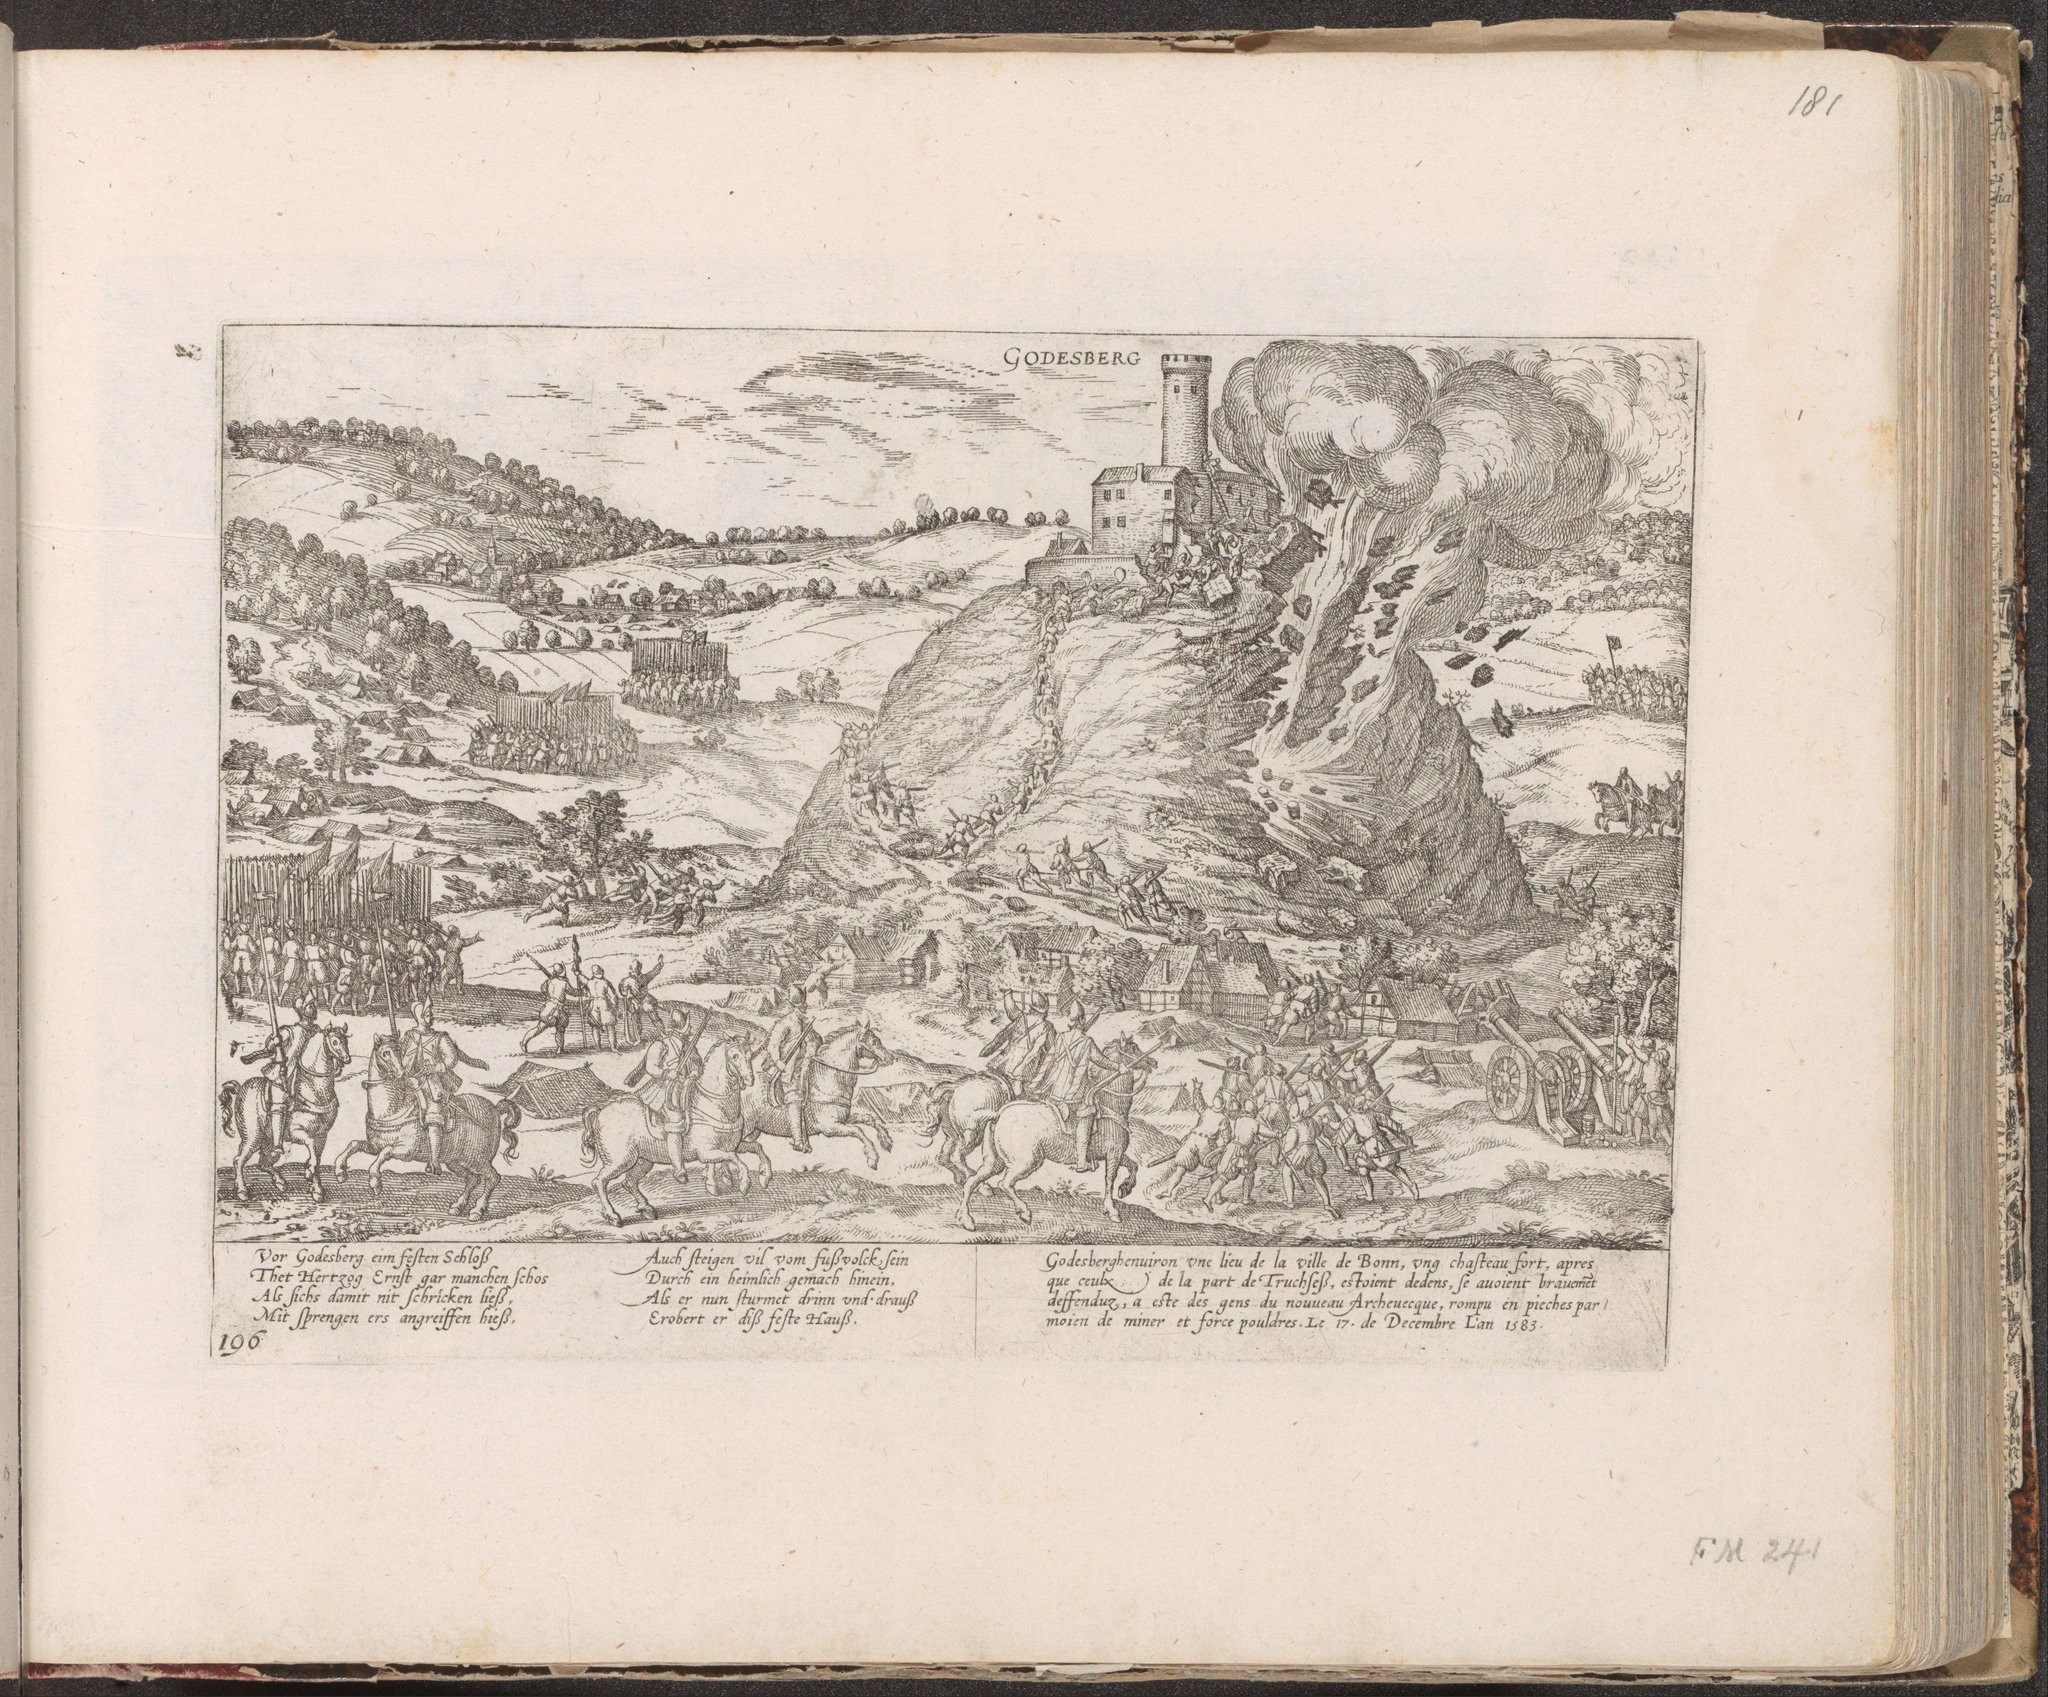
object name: album leaf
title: Inname en verwoesting van Godesberg, 1583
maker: frans hogenberg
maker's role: print maker, publisher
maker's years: 1538-1590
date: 1587-1591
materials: paper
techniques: etching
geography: cologne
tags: capture of city (after the siege), destruction of conquered city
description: Inname en verwoesting van Godesberg, 17 december 1583. Episode uit de Keulse Oorlog. Met onderschrift van 8 regels in het Duits en 4 regels in het Frans. Linksonder genummerd: 196. De prent maakt deel uit van een album.